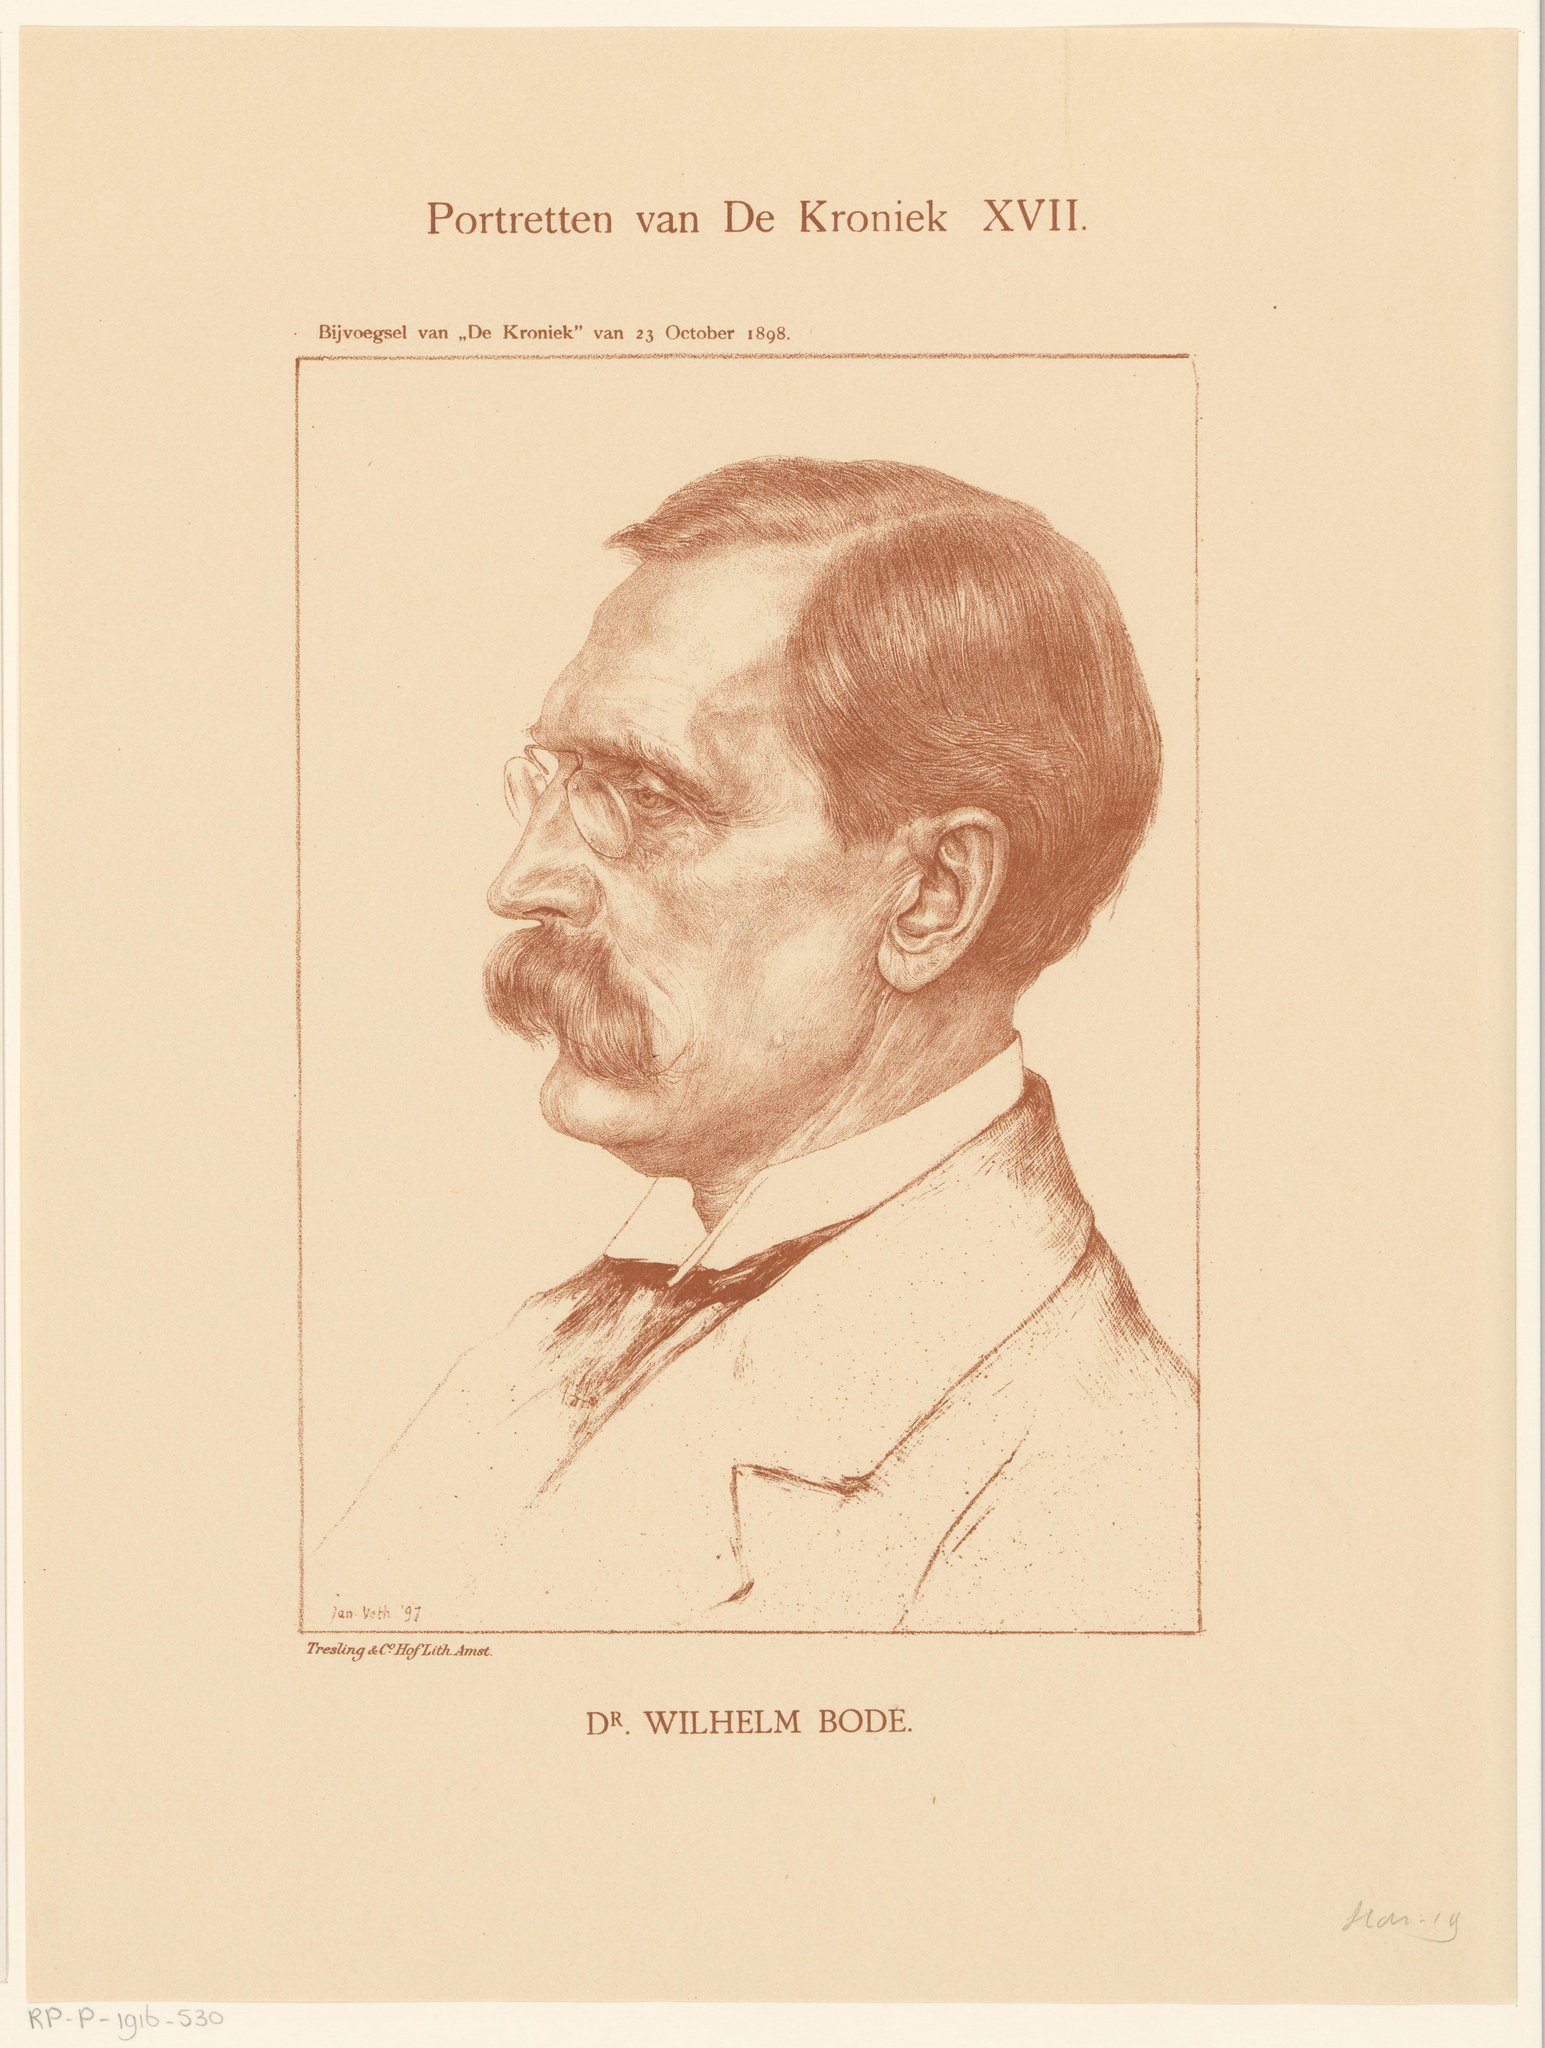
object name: print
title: Portretten van De Kroniek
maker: jan veth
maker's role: designer, draughtsman, painter, print maker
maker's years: 1864-1925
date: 1897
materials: paper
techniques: lithograph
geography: amsterdam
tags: wilhelm von bode, historical persons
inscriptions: collector's mark: Lugt 2228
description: Dit portret werd uitgegeven als bijvoegsel bij De Kroniek op 23 oktober 1898.